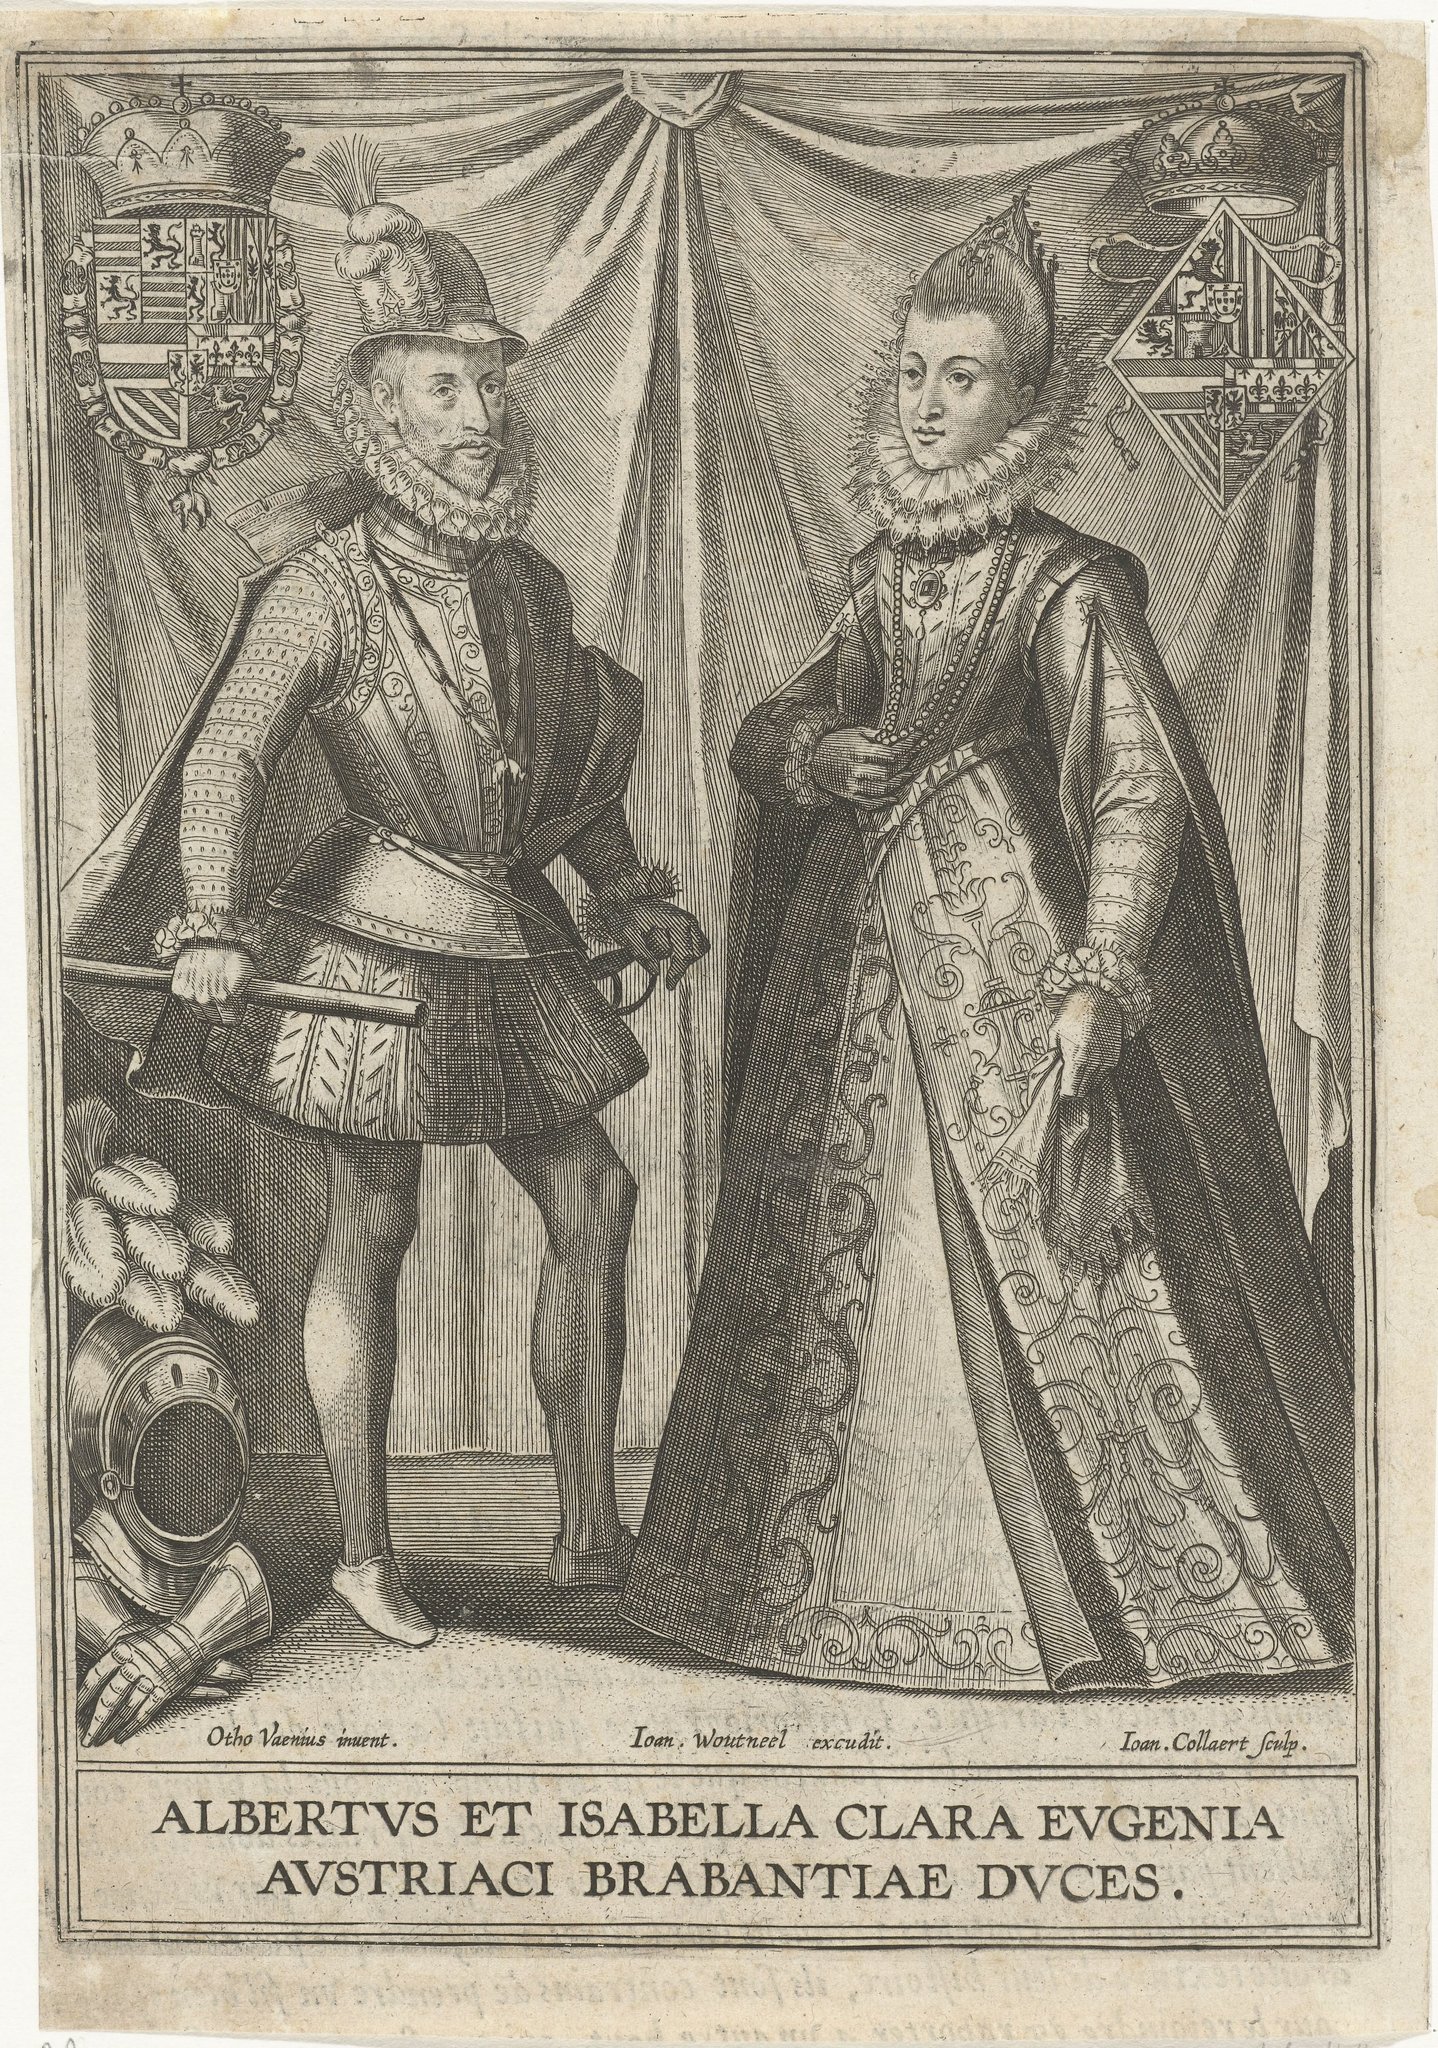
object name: print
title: Albertvs et Isabella Clara Evgenia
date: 1600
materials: paper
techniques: engraving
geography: antwerp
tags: infante van spanje isabella clara eugenia, brussels, albrecht aartshertog van oostenrijk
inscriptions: collector's mark: Lugt 2228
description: Portret van aartshertogen Albrecht en Isabella, landvoogden van de Zuidelijke Nederlanden. Links staat Albrecht van Oostenrijk, een baton in zijn hand. Naast hem zijn wapenrusting. Rechts Infanta Isabella van Spanje. In de linker- en de rechterbovenhoek hun respecievelijke wapenschilden.